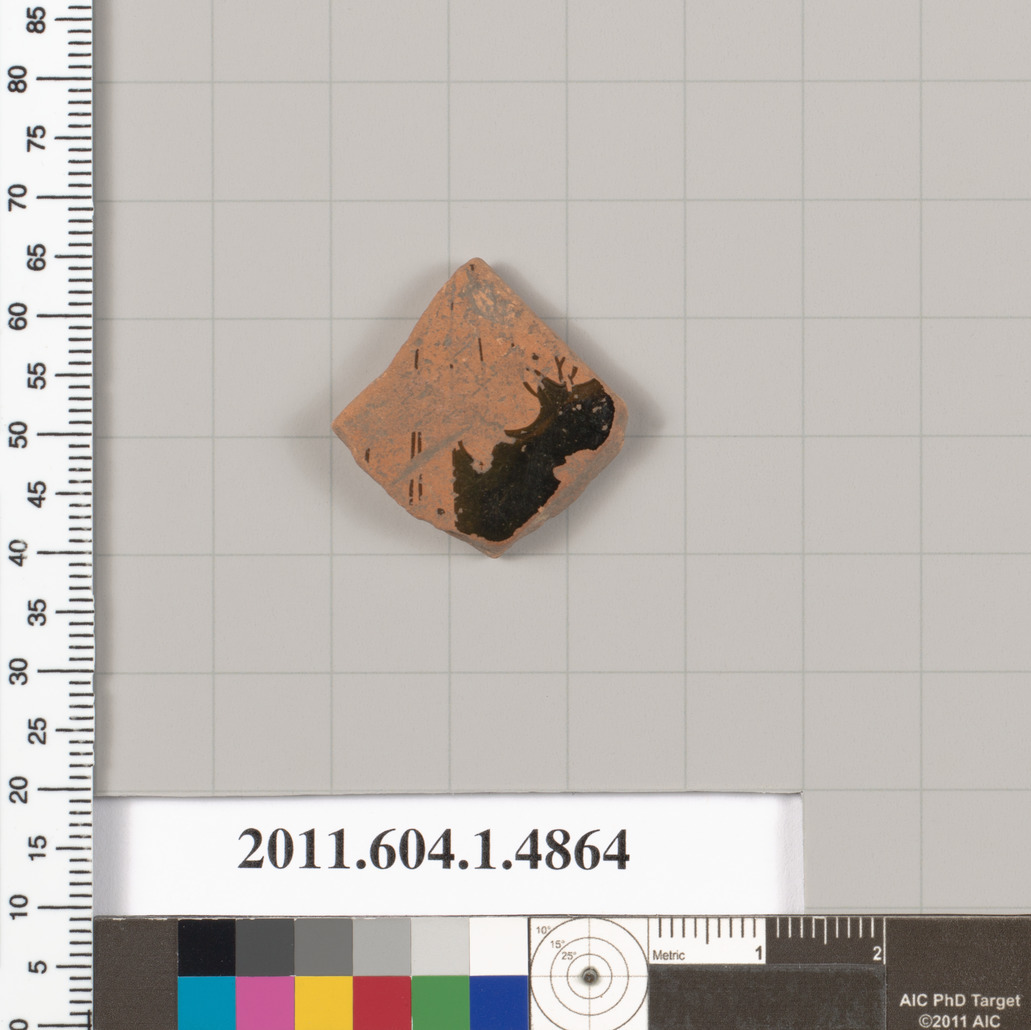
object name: kylix fragment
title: Terracotta fragment of a kylix (drinking cup)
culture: greek, attic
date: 490-470 BCE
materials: terracotta